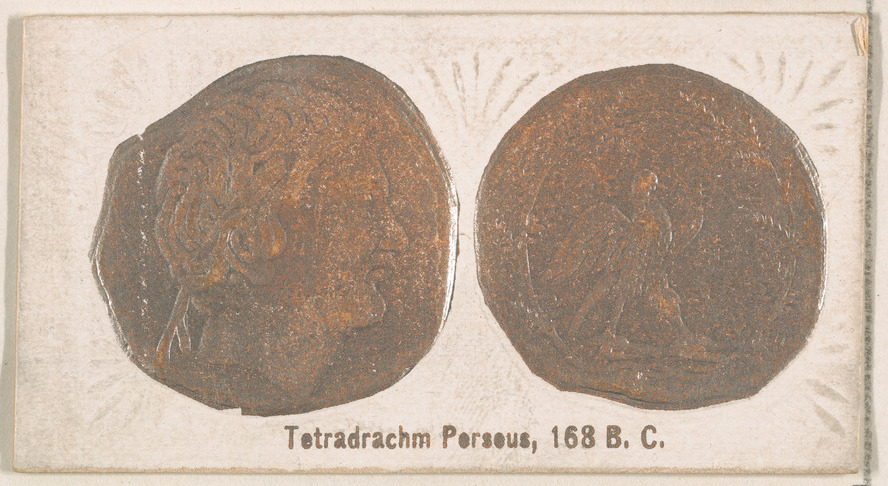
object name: print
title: Tetradrachm Perseus, 168 B.C., from the Ancient Coins series (N180) issued by Wm. S. Kimball & Co.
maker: william s. kimball & company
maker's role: publisher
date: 1888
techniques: color lithograph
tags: coins